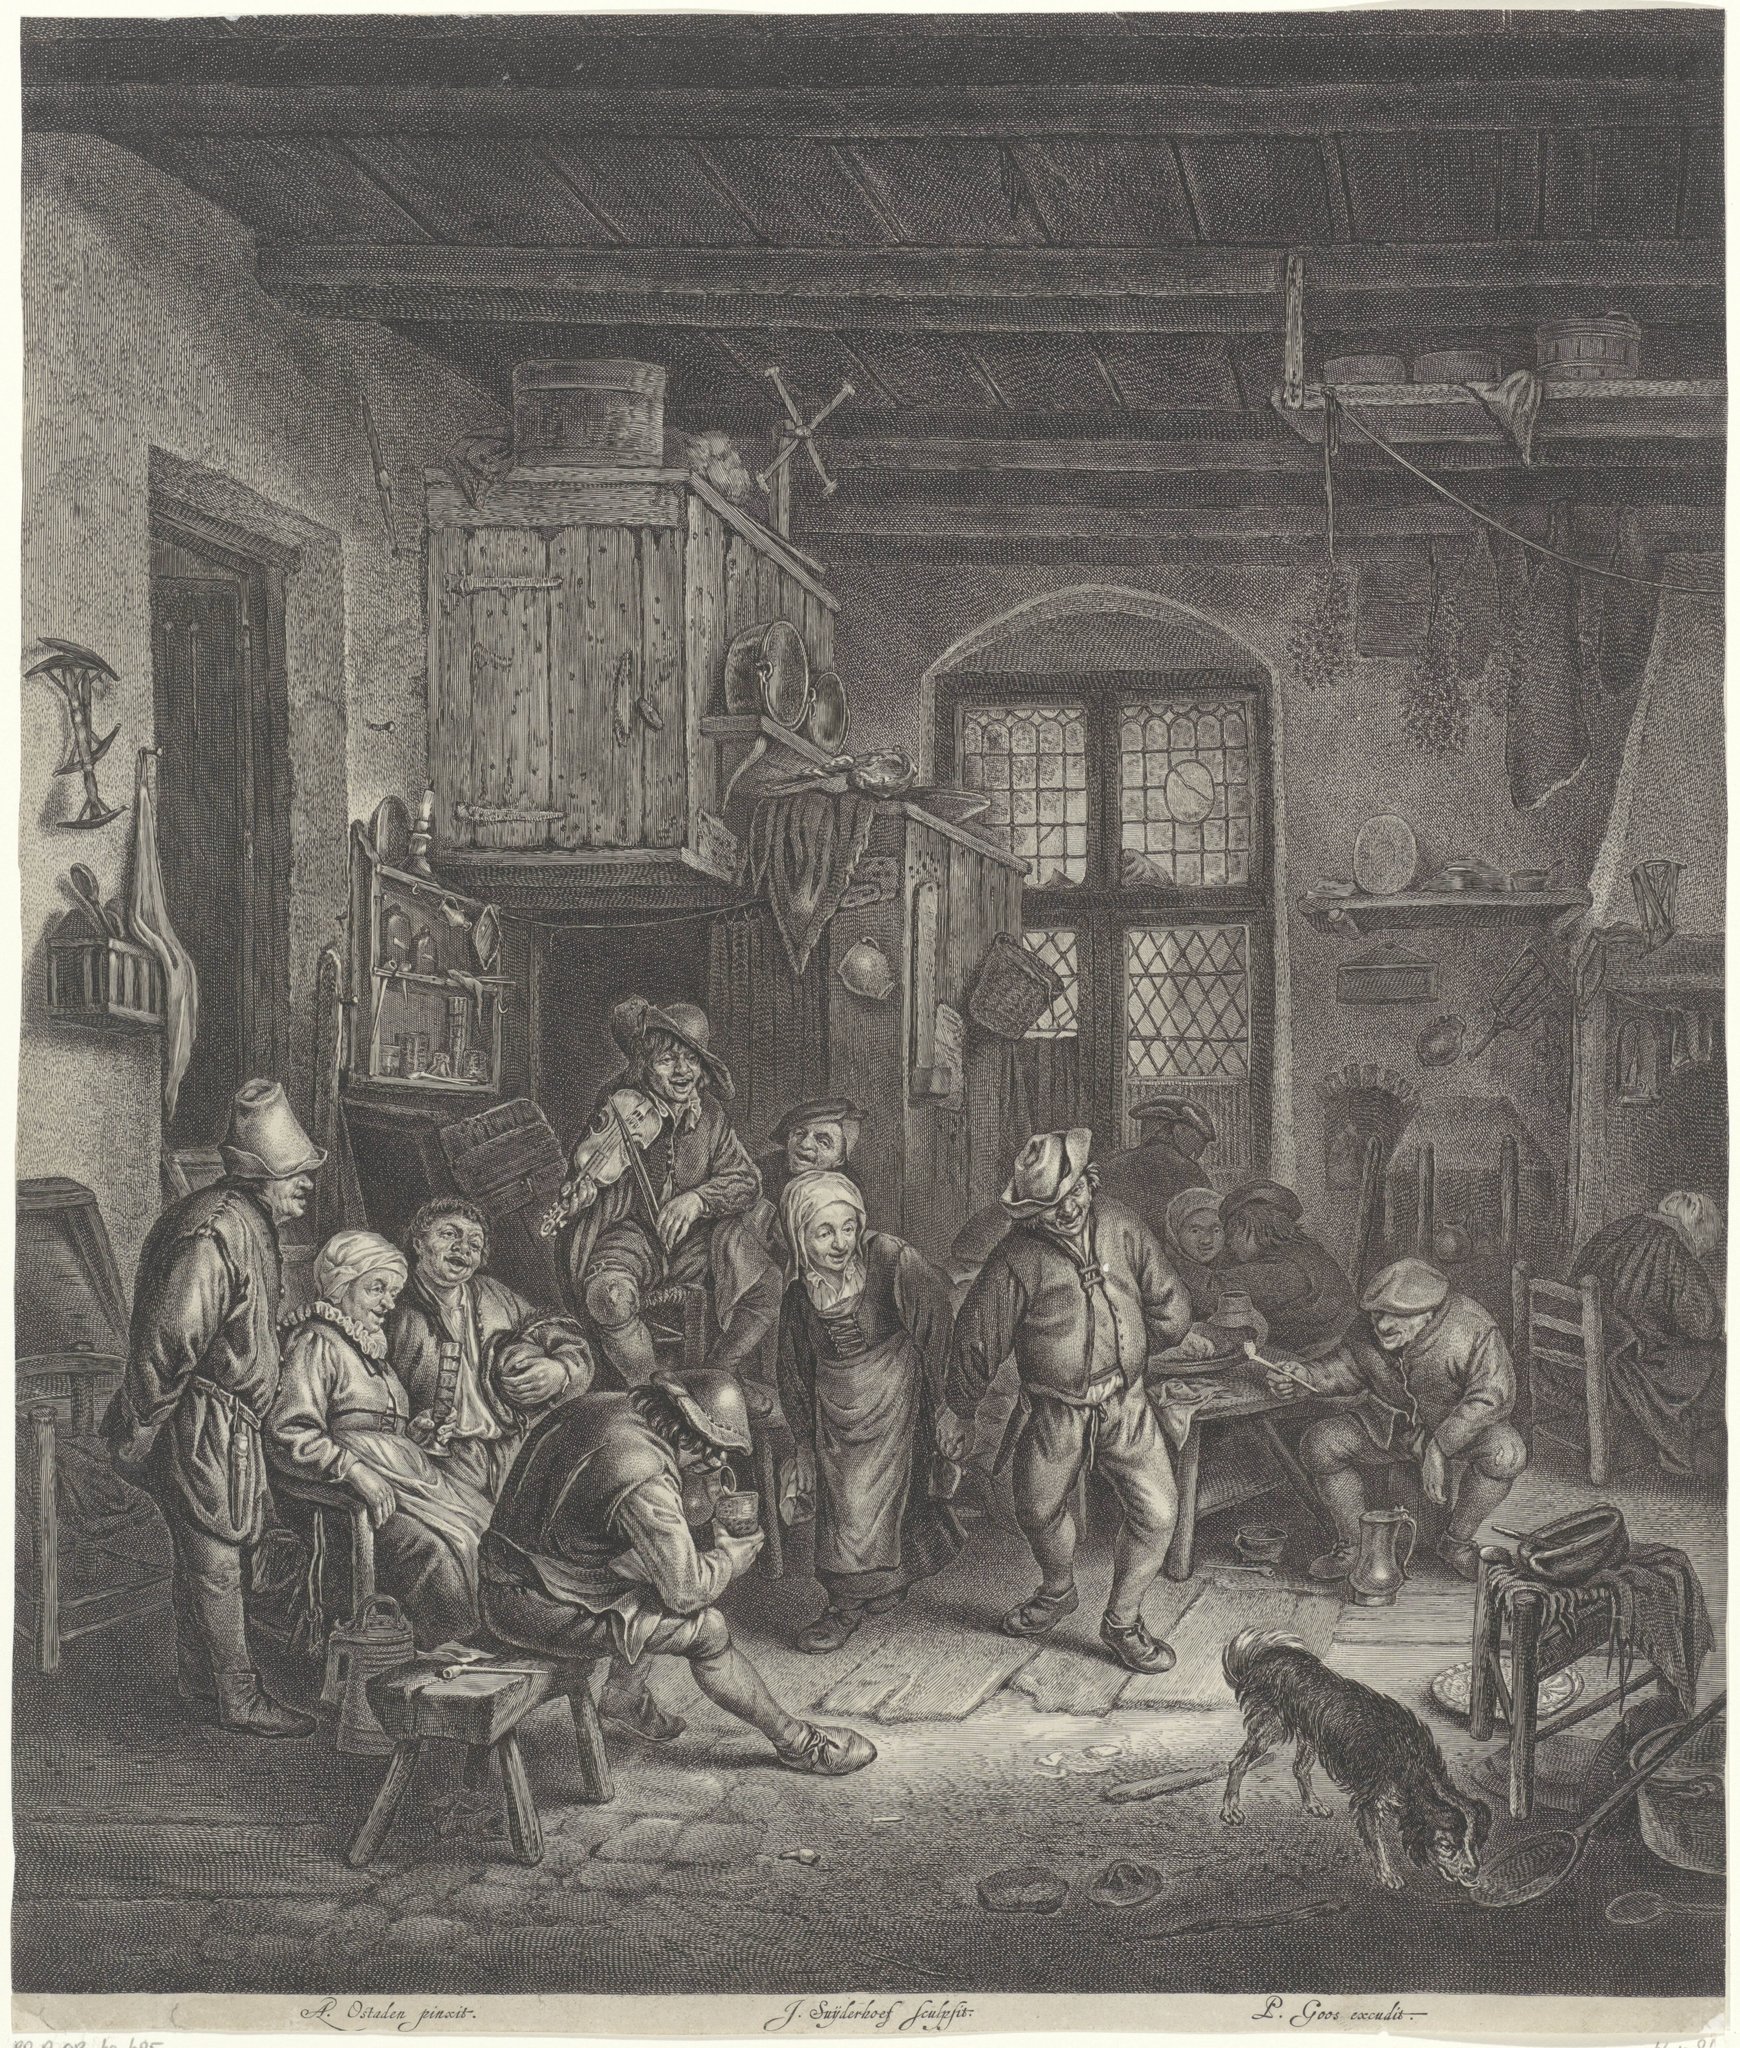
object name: print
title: Boereninterieur met dansend paar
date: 1657-1672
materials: paper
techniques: engraving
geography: amsterdam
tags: inn, coffee-house, public house, etc., violin, fiddle, one pair dancing; man and woman dancing as a couple, vocal music, singing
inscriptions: collector's mark: Lugt 240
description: In een herberginterieur maken een oude vrouw en een oude man hand in hand een dansje. Links van hen een vioolspeler en zingende en drinkende mensen. Rechts een zittende man met een pijp in zijn hand. Rechts op de voorgrond een hond.